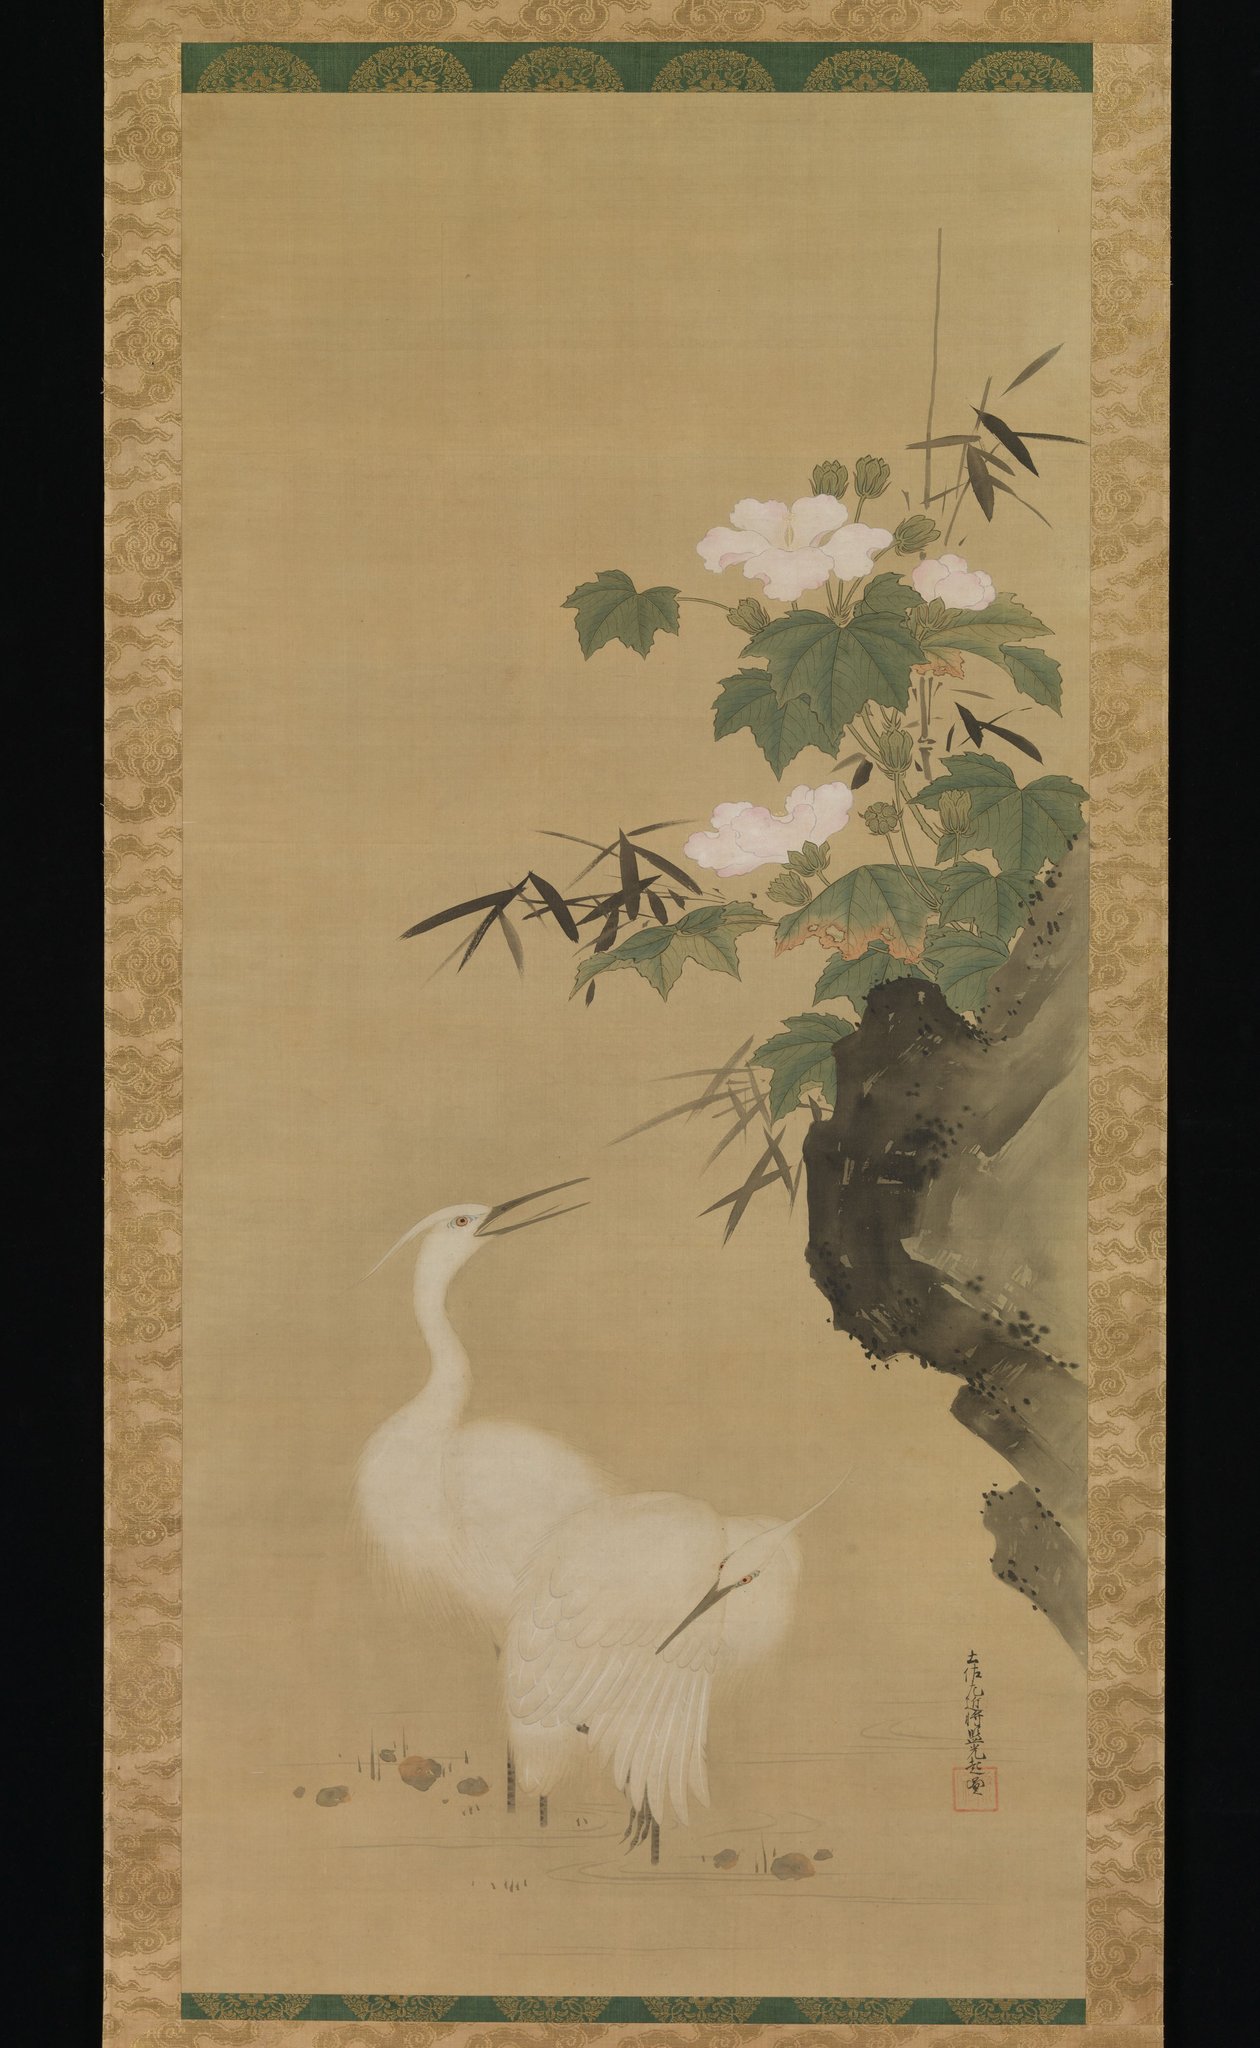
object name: hanging scroll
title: Egrets and Cotton Roses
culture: japanese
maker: tosa mitsuoki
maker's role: artist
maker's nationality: japanese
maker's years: 1617-1691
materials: ink, silk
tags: birds,roses